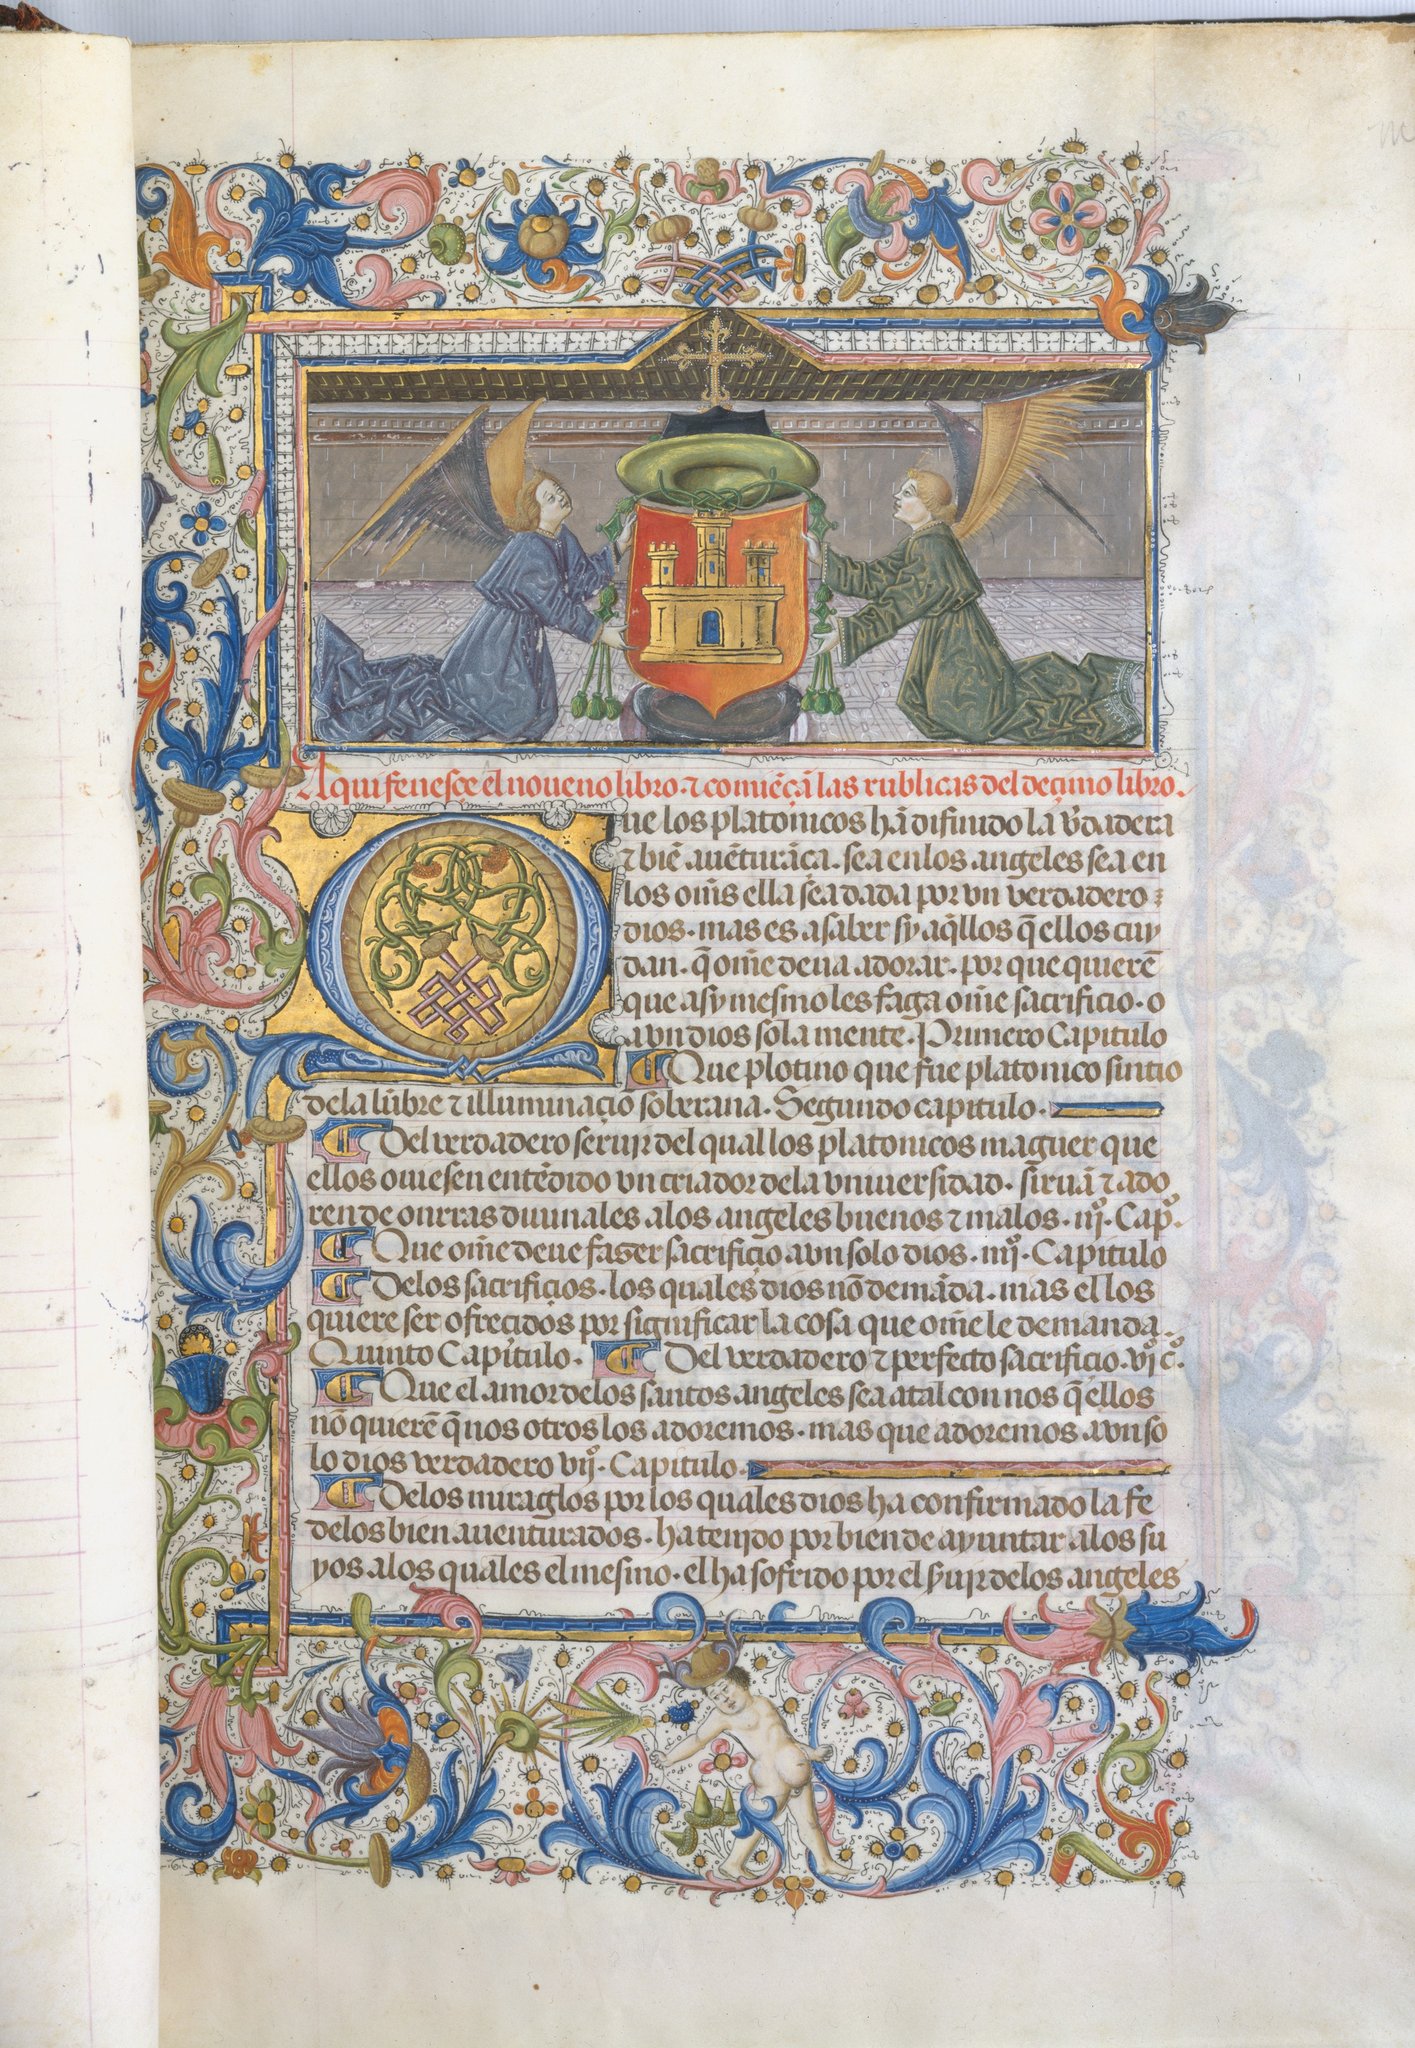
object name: manuscript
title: Spanish Translation of Saint Augustine's "City of God"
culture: spanish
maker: cano de aranda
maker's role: artist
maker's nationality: spanish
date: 1446-1482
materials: gold, leather, parchment, paint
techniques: bookbinding, tooling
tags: coat of arms